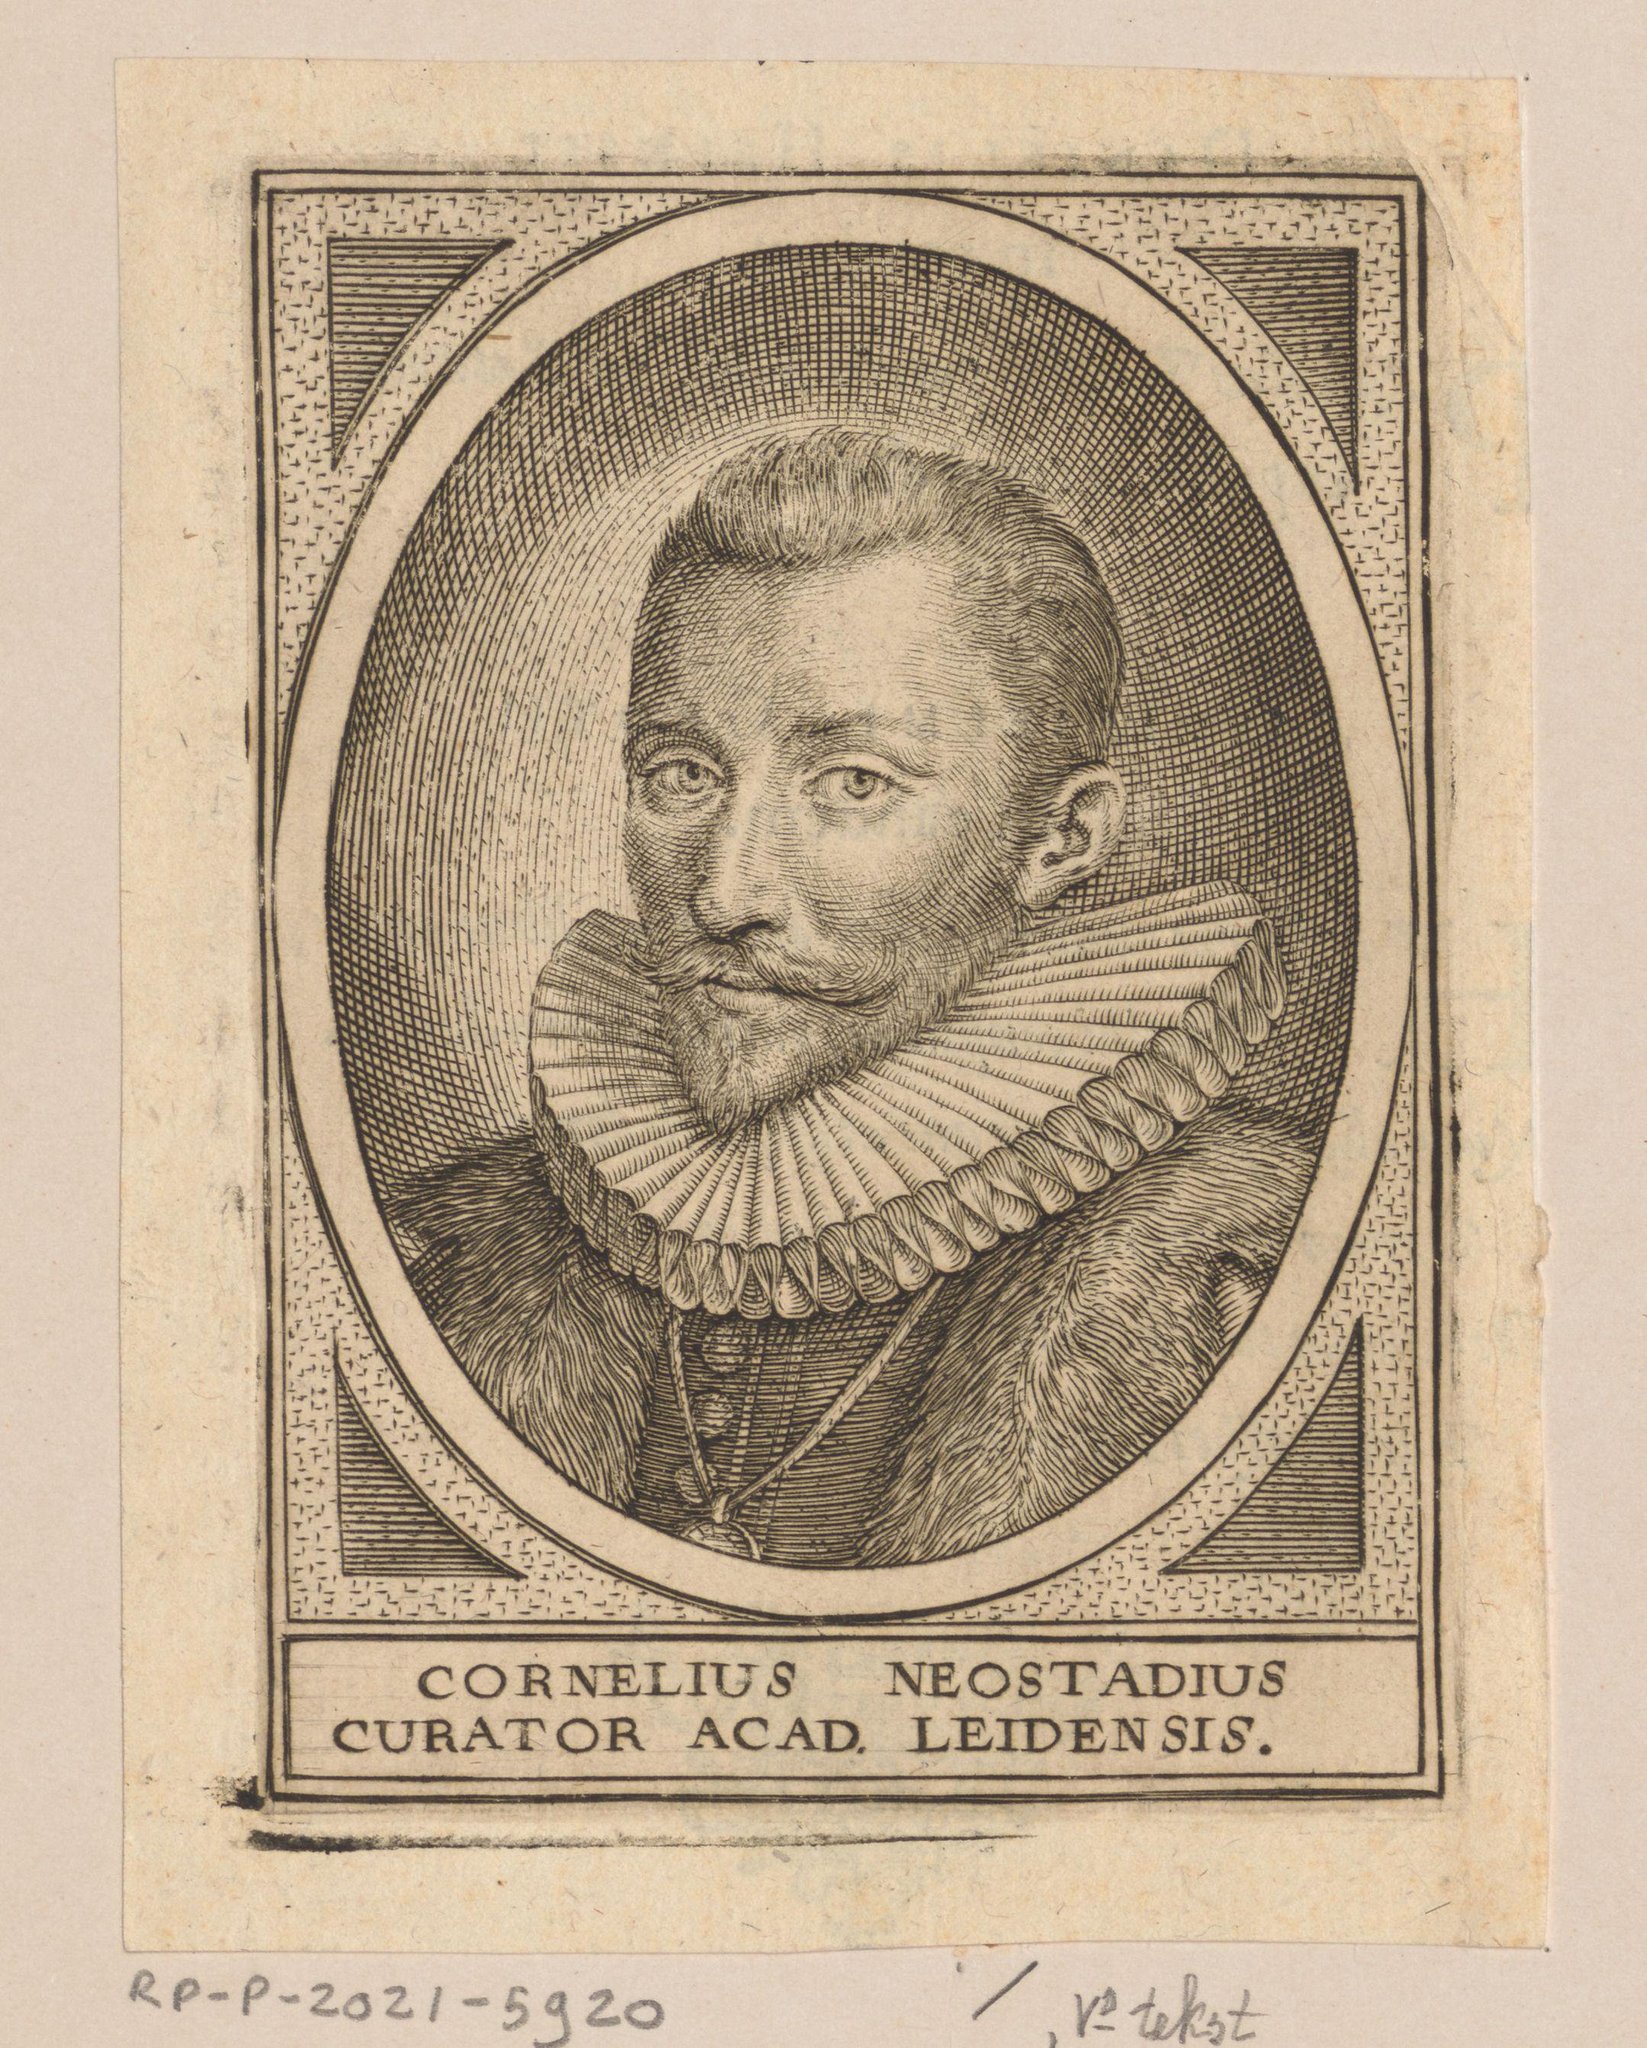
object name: book illustration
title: Portret van Cornelis Matthiasz van Nieuwstadt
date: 1614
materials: paper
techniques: engraving, letterpress printing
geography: leiden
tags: the hague, historical persons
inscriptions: collector's mark: Lugt 2228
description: Prent uit: Illustrium Hollandiae & Westfrisiae ordinum alma academia Leidensis. Leiden: Jacob Marcus en Joost van Colster, 1614.